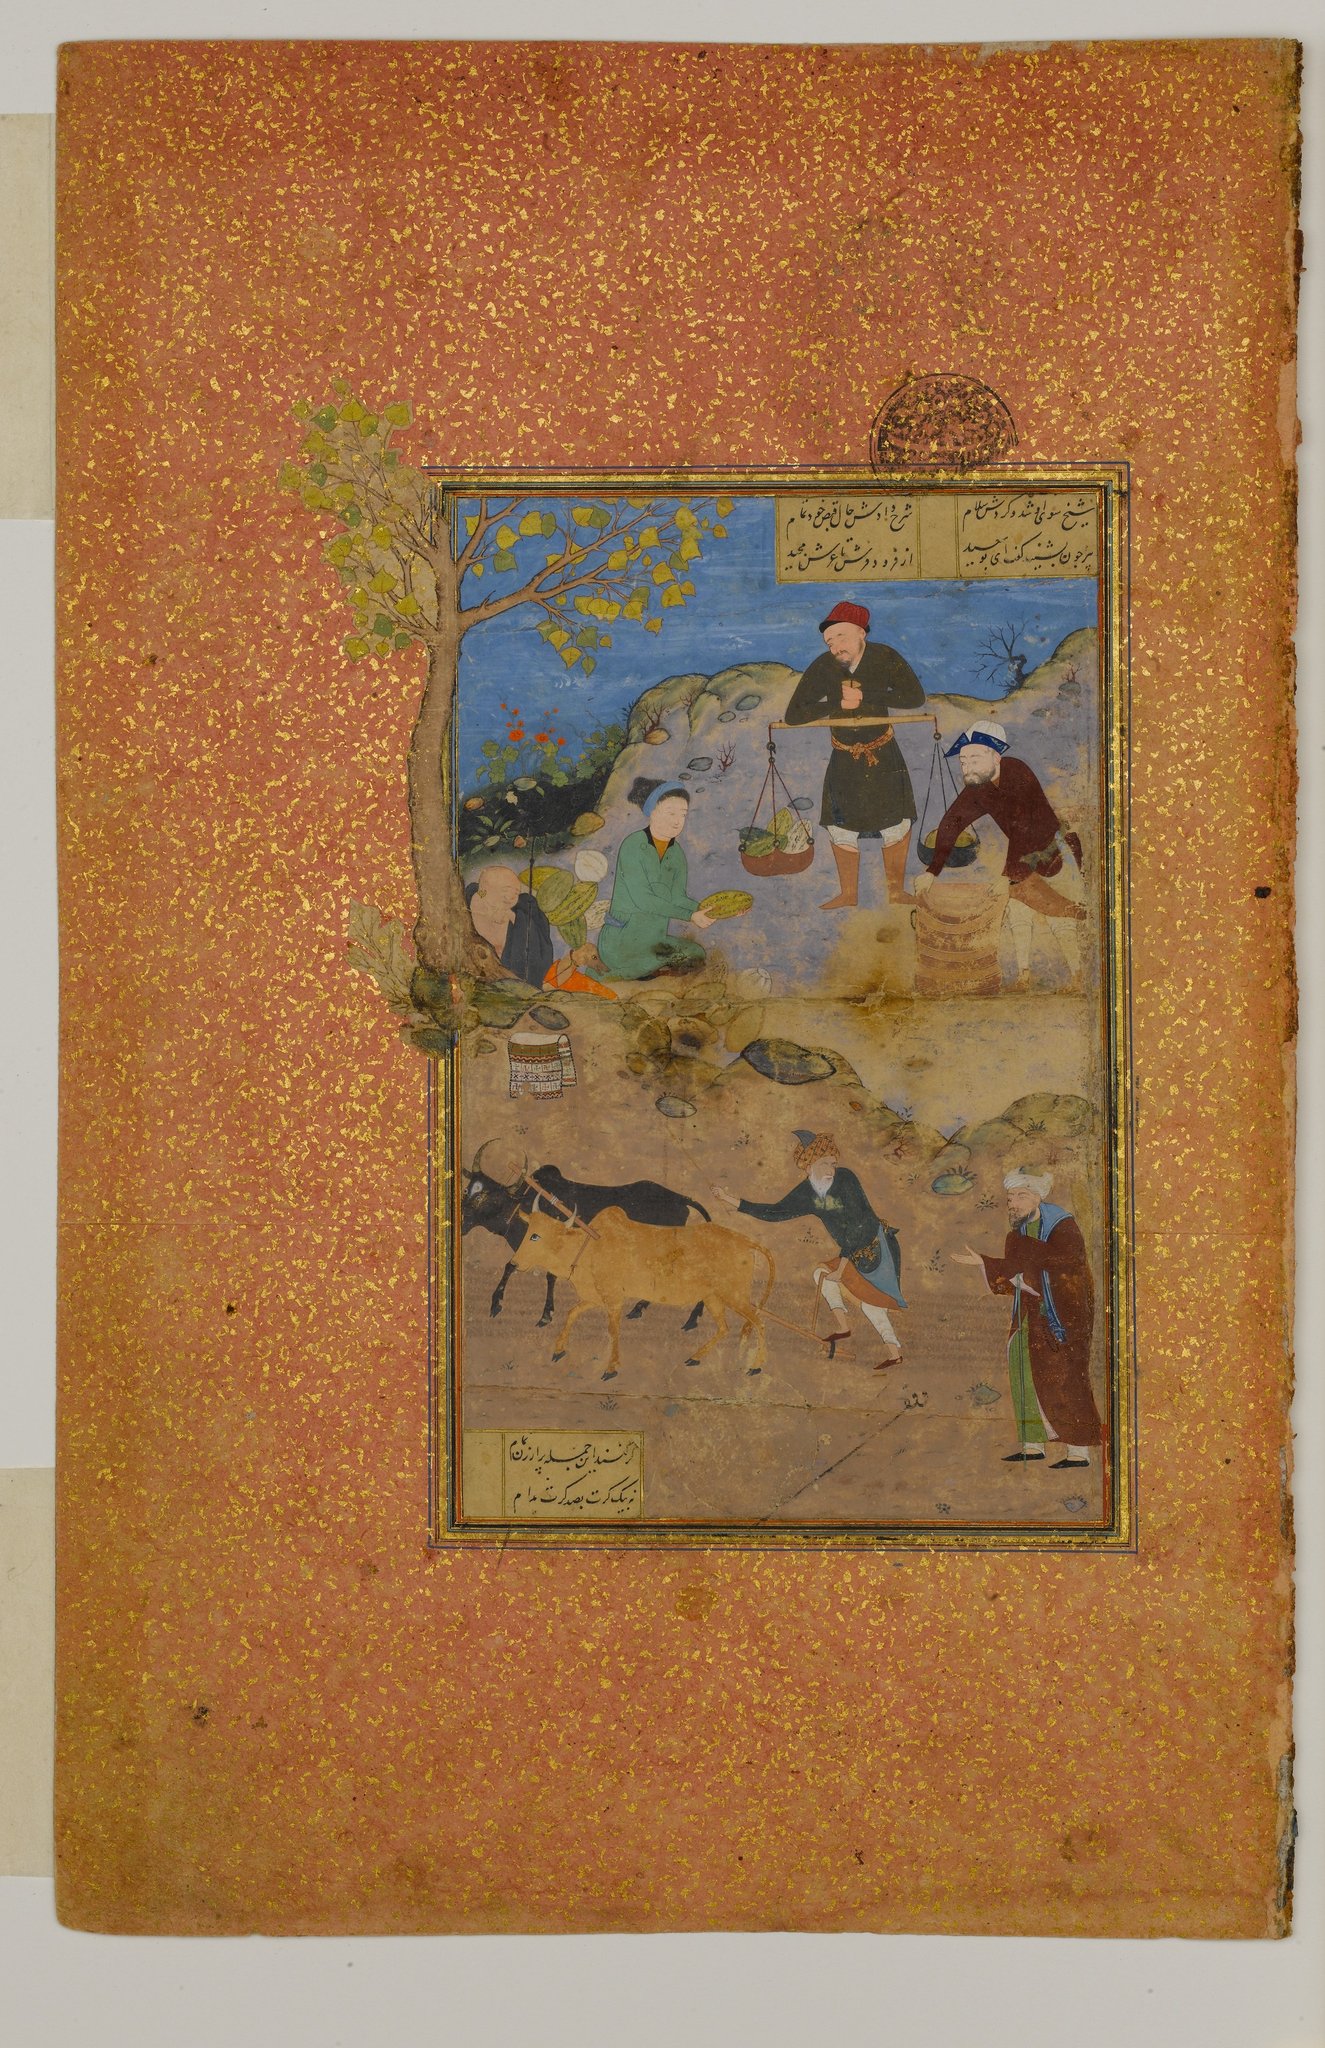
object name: folio from an illustrated manuscript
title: "Shaikh Mahneh and the Villager", Folio 49r from a Mantiq al-Tayr (Language of the Birds)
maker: farid al-din `attar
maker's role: author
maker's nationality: iranian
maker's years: 1142-1220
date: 1487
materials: gold, paper, silver, watercolor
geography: afghanistan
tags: fruit,men,scales,ox